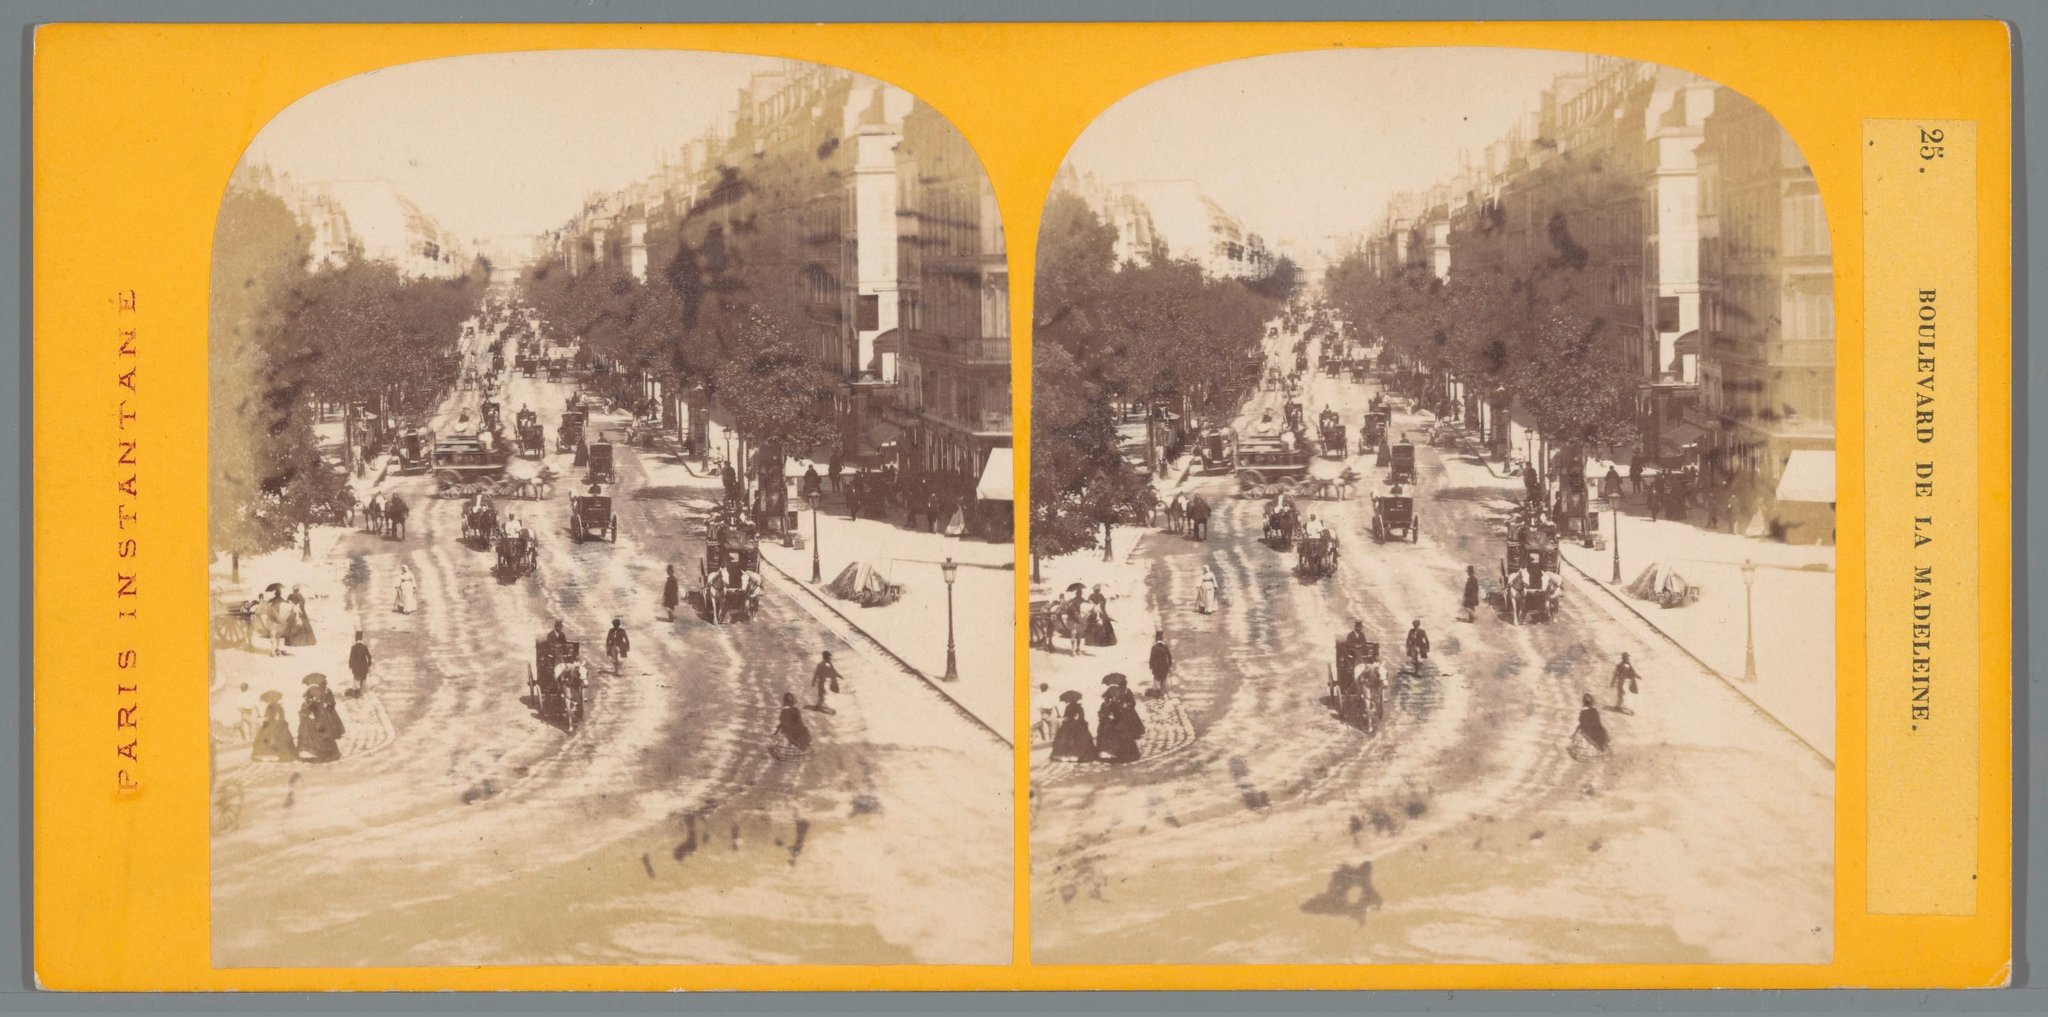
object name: stereograph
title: Boulevard de la Madeleine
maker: Anonymous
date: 1850-1880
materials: cardboard, photographic support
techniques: albumen print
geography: paris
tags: animal traction, animal-drawn vehicle (carriage etc.), street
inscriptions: number: ‘25.’